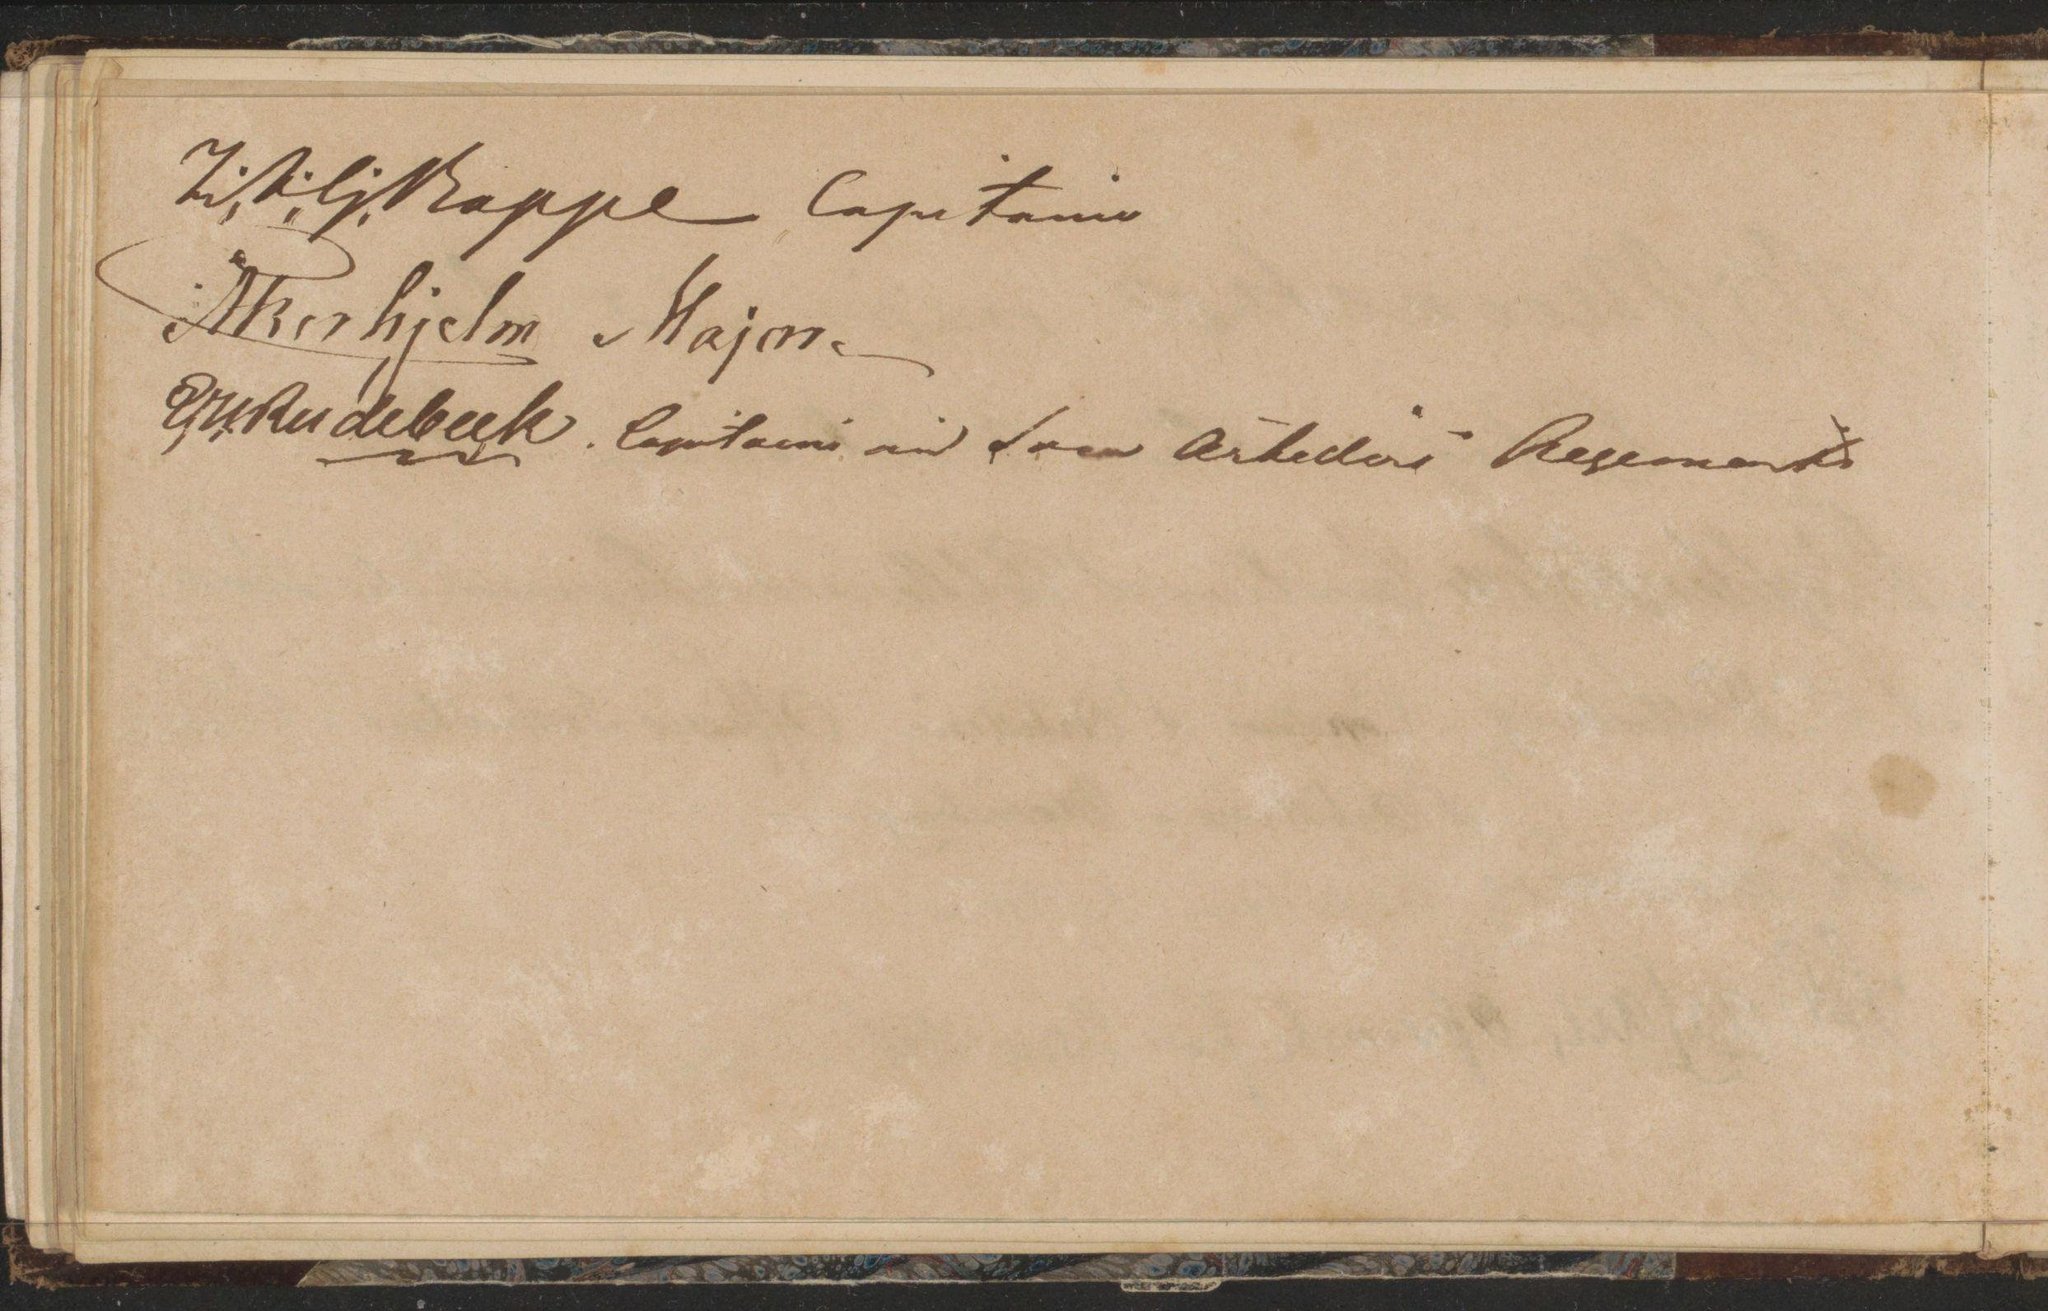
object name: sketchbook leaf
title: Namen van Zweedse militairen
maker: christian heinrich gottlieb steuerwald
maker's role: draughtsman, print maker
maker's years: 1802-1874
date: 1845-1848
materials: ink, paper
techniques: pen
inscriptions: annotation: ‘...’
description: Blad 18 verso uit een schetsboek met 61 bladen.